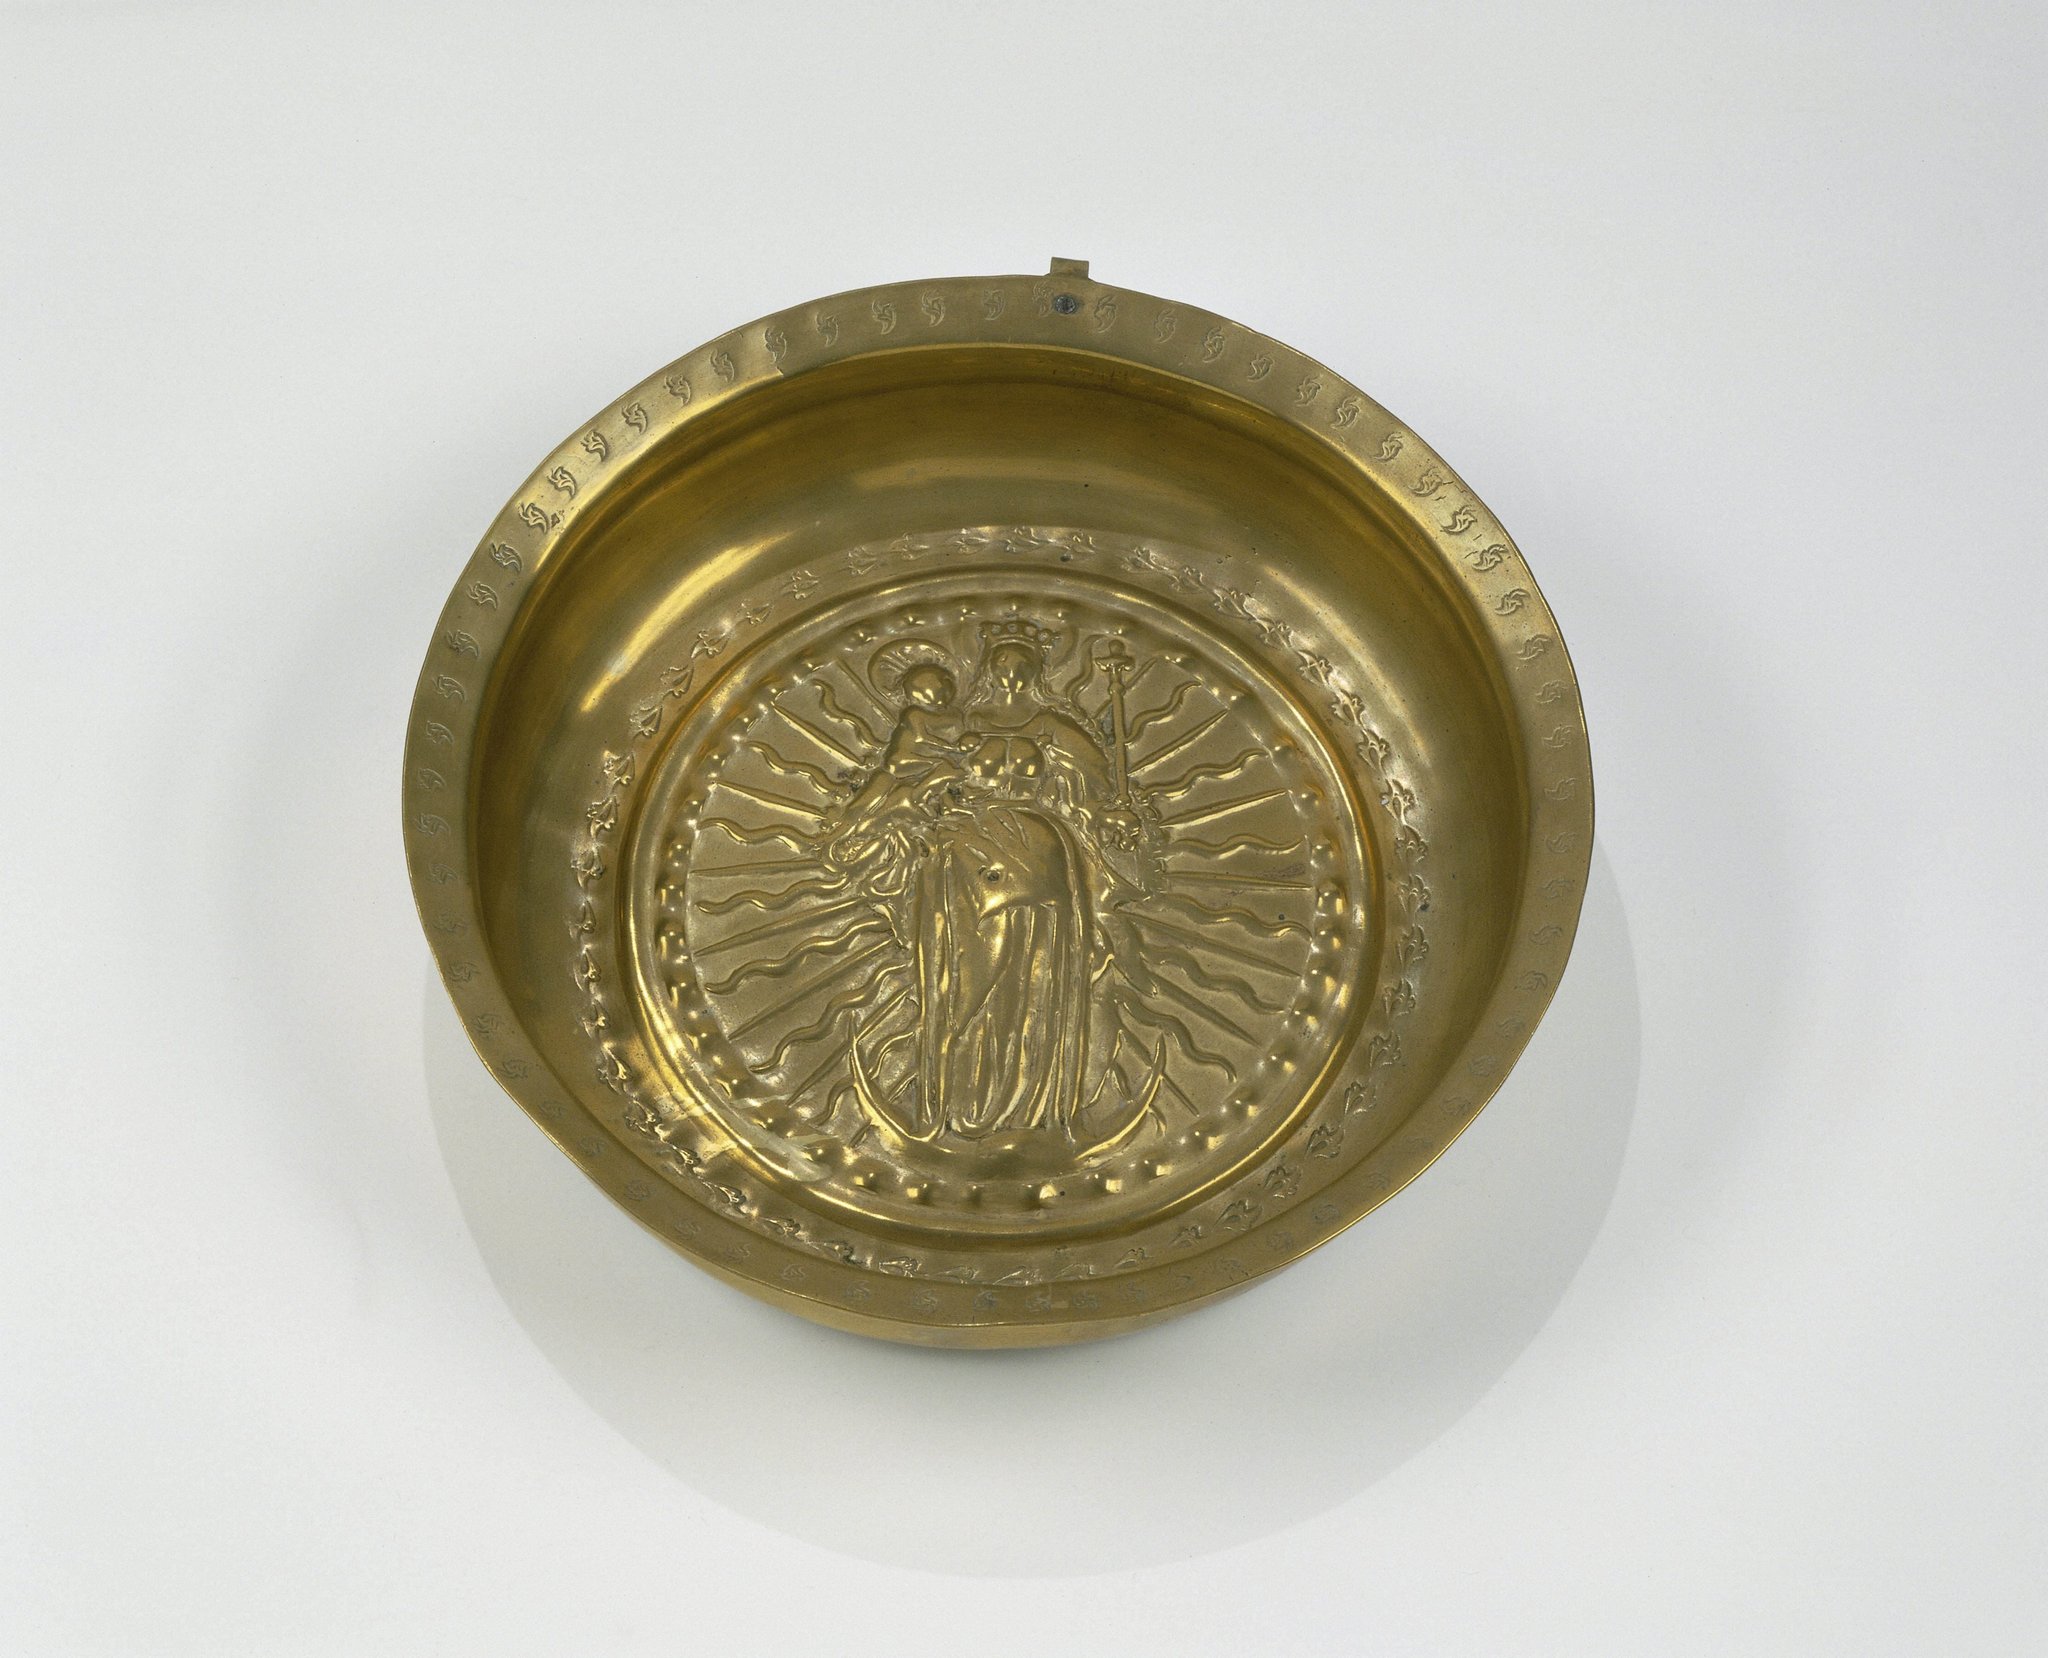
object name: bekken schaal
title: Bekken met een voorstelling van Maria met kind op de maansikkel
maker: Anonymous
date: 1500-1550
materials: brass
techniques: casting, punching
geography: nuremberg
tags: madonna on the crescent of the moon (sometimes called queen of heaven) (in mandorla)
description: In het plat van het bekken, dat in het midden het centerpunt heeft, is met behulp van een stempelvorm een voorstelling geponst van de gekroonde Maria met het kind op de maansikkel, omgeven door een stralenkrans. Deze is omgeven door een geponste rand van gestileerd bladornament. Een uit een dergelijk motief samengestelde versiering is eveneens op de boord van het bekken geponst. In latere tijd is bovenaan een hangring met ijzer geklonken en aan de achterkant is een hangring gesoldeerd.